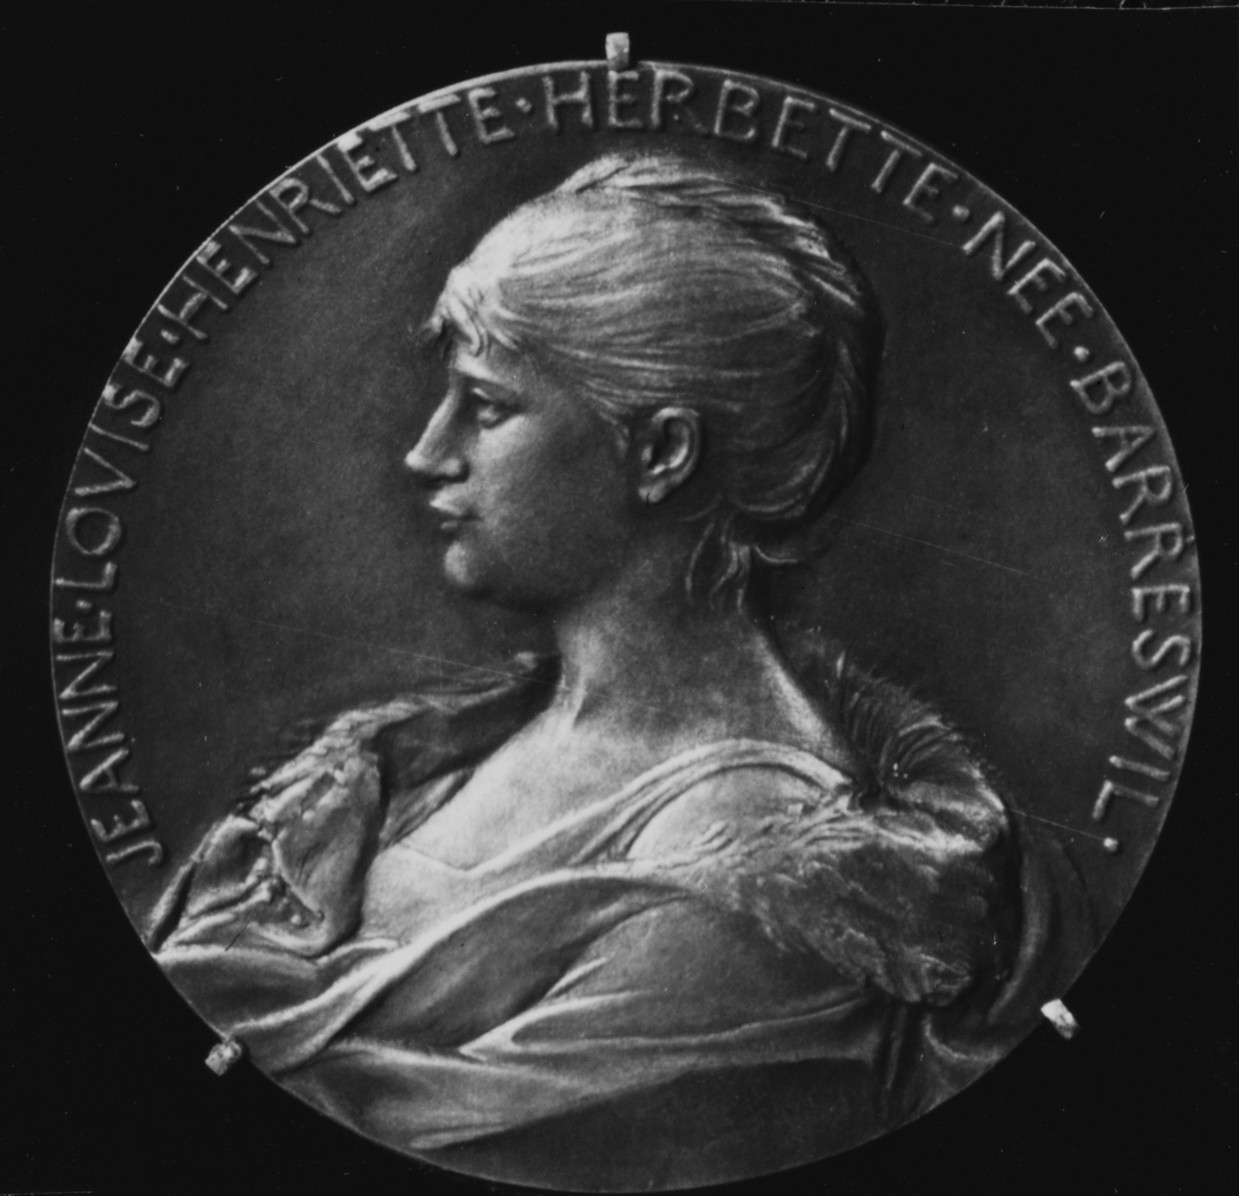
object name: medal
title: Portrait of Mme. Herbette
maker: louis-oscar roty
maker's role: artist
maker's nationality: french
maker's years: 1846-1911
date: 1887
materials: bronze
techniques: casting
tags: profiles,women